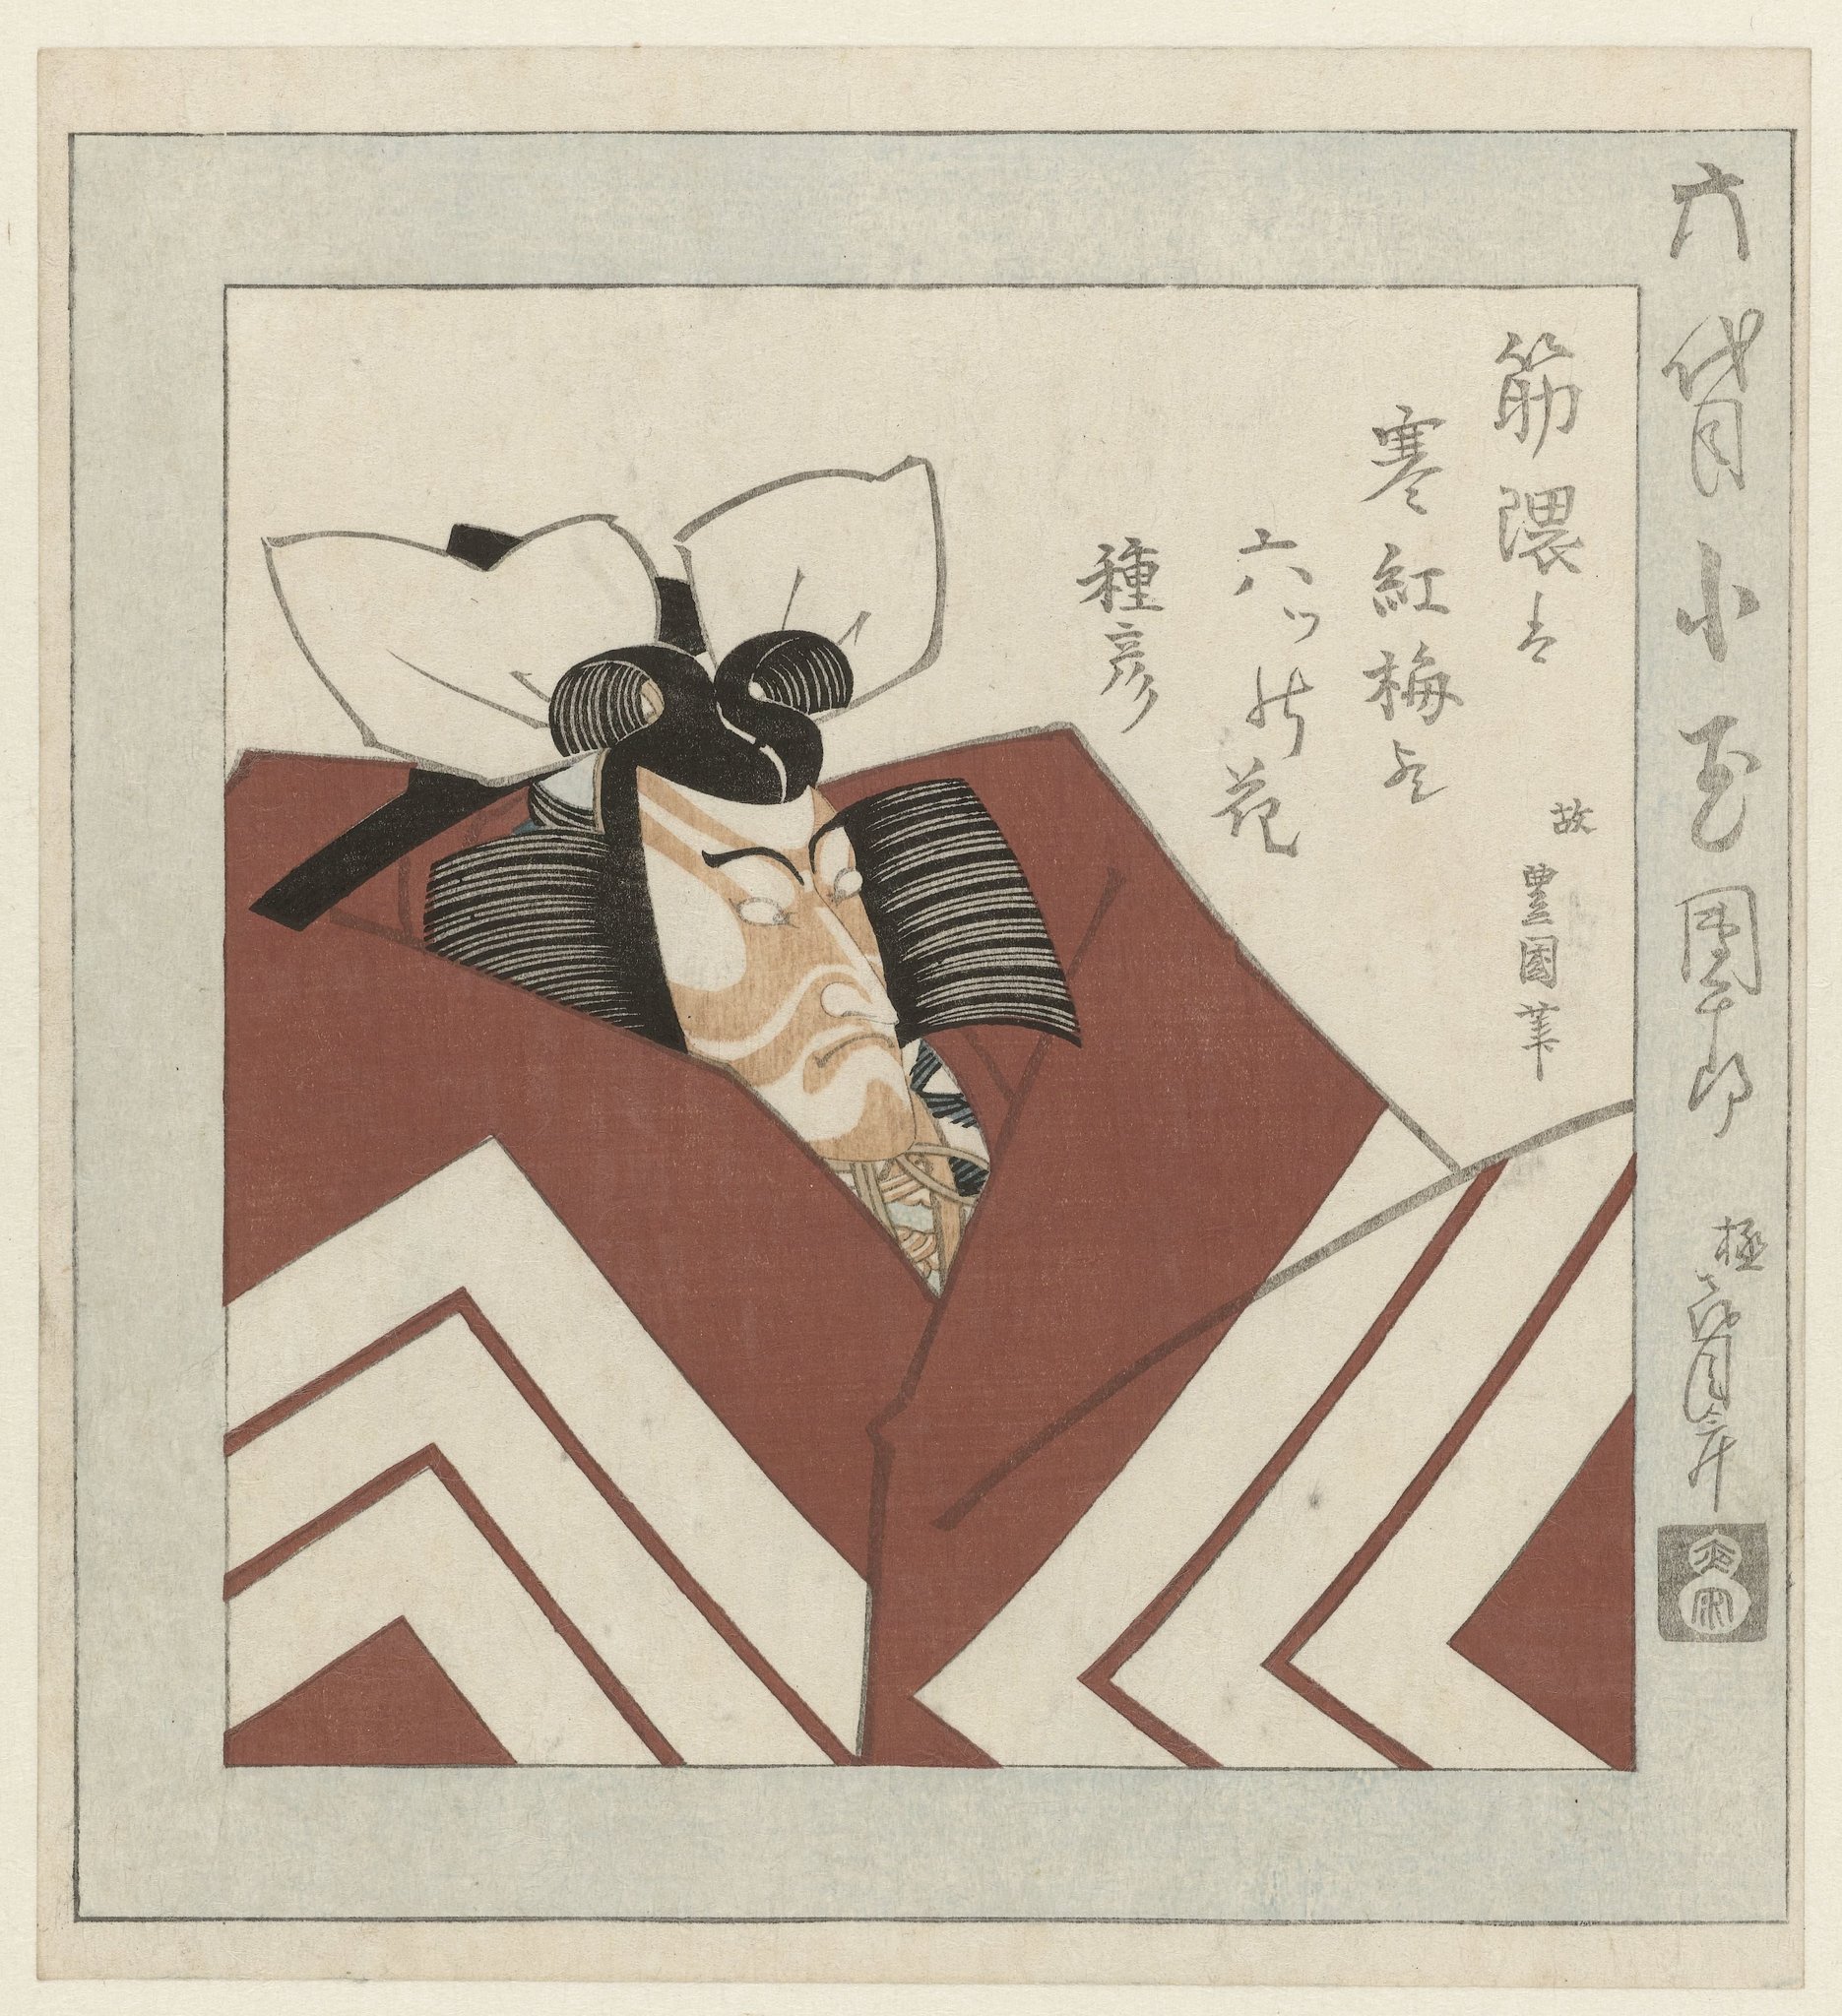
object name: print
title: The Kabuki Actor Ichikawa Danjûrô VI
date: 1825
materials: paper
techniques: woodcut, polish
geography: japan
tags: portrait of actor, actress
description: Een surimono is een luxe uitgevoerde prent waarop beeld met één of meerdere gedichten gecombineerd is. Bij het drukken van een surimono werd vaak gebruik gemaakt van dikker papier, blinddruk en metaal pigmenten, zoals koper- en zilverpoeder. De prenten werden vaak in opdracht van dichters gemaakt en als exclusief geschenk aan vrienden en relaties gegeven.